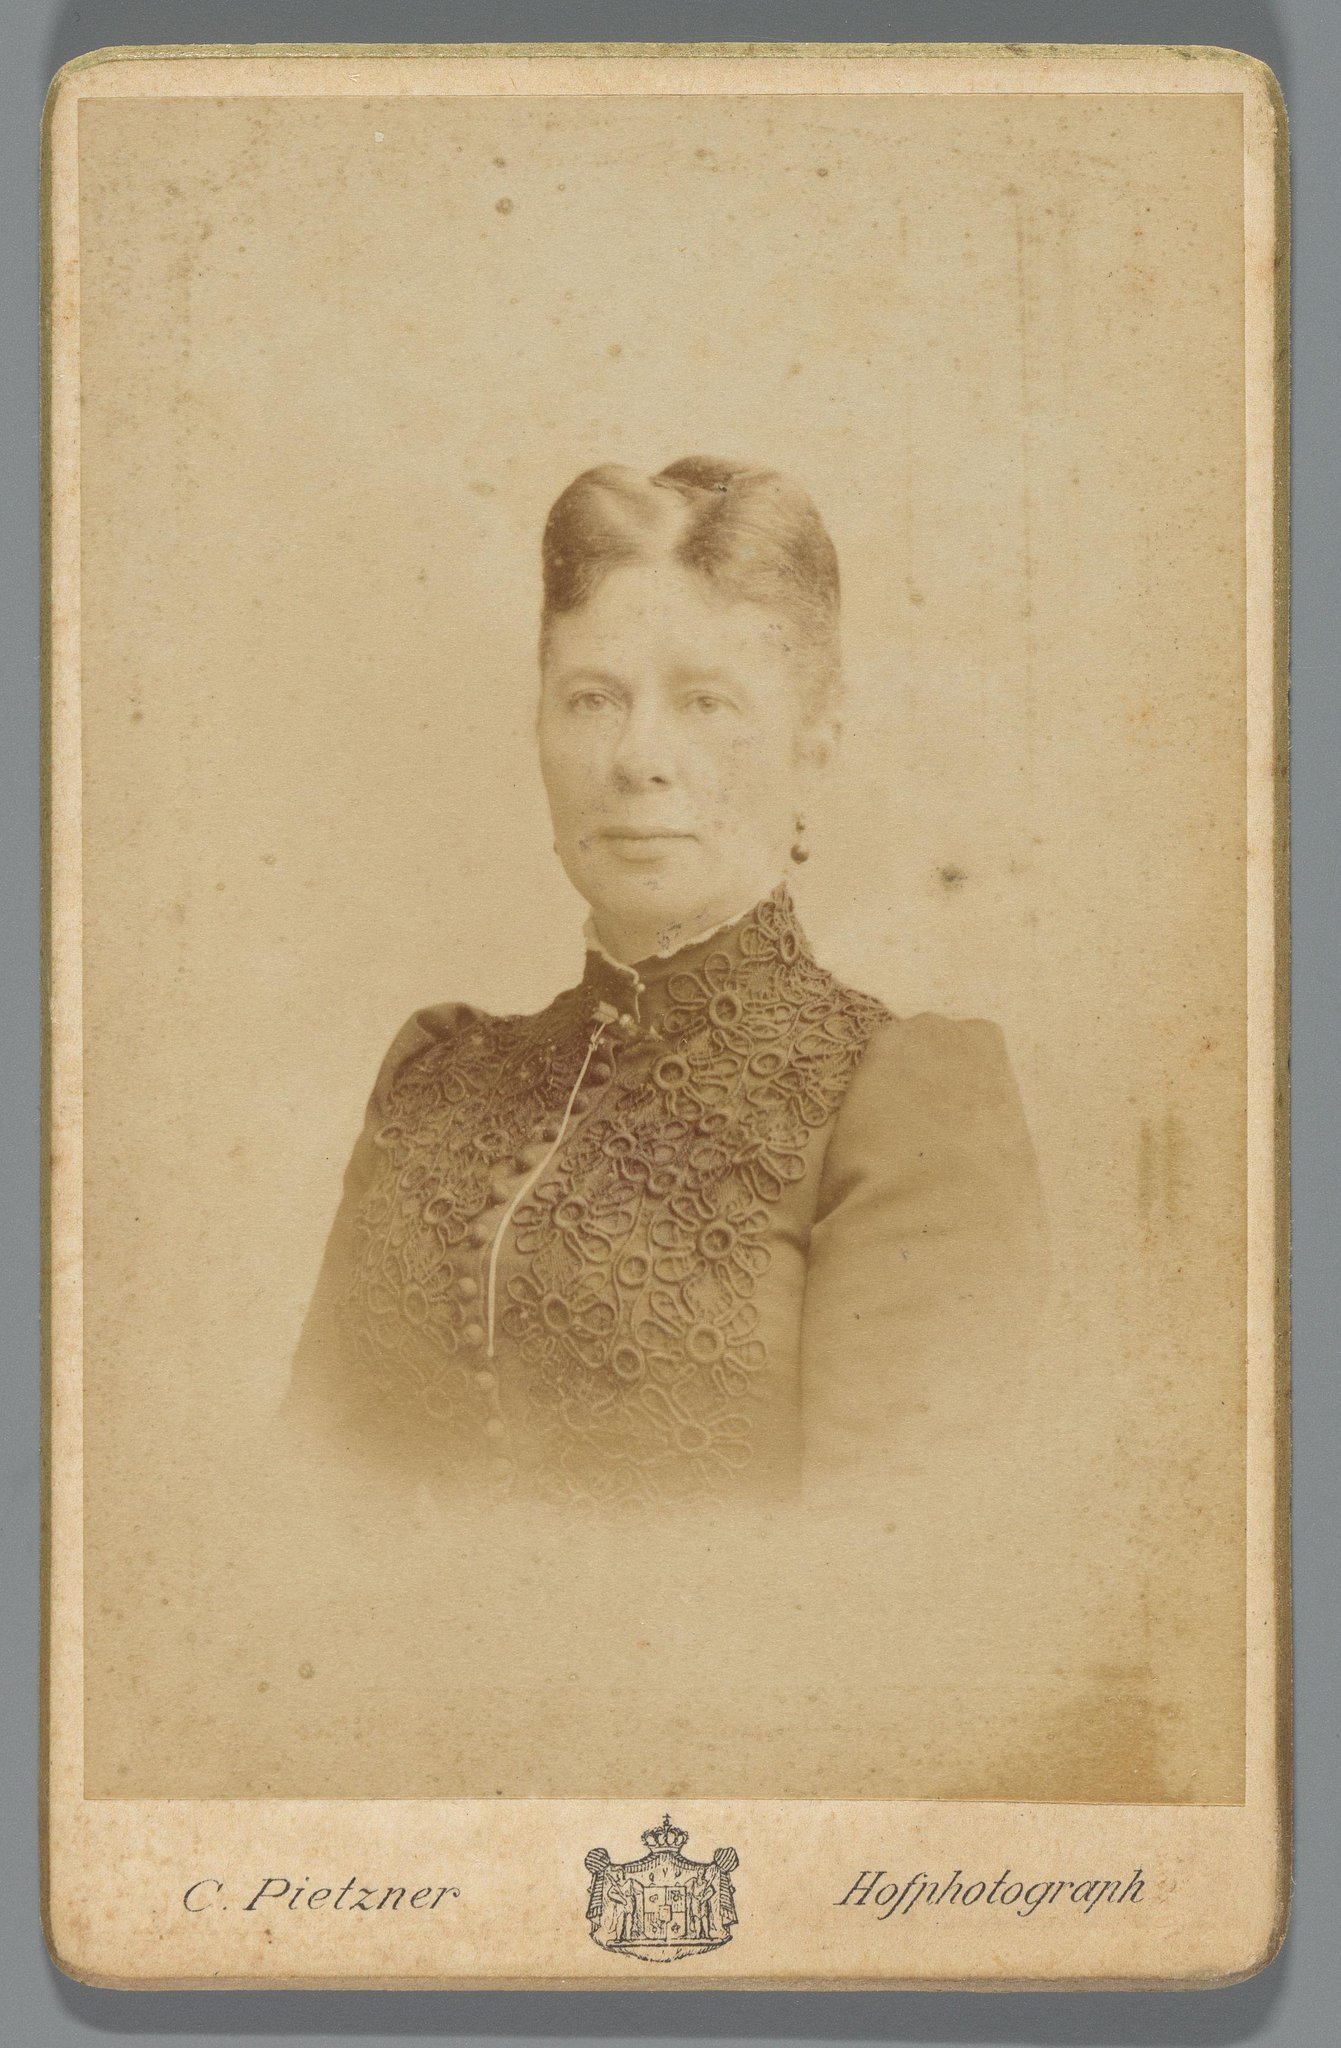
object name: carte de visite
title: Portret van Pauline Hoogeveen-Holle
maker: carl pietzner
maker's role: fotograaf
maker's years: 1853-1927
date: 1870-1920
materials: cardboard, photographic support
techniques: albumen print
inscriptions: name: ‘Emilie..’, name: ‘C. Pietzner Hofphotograph’, name: ‘P. Hoogeveen / Holle /’, number: ‘7715’